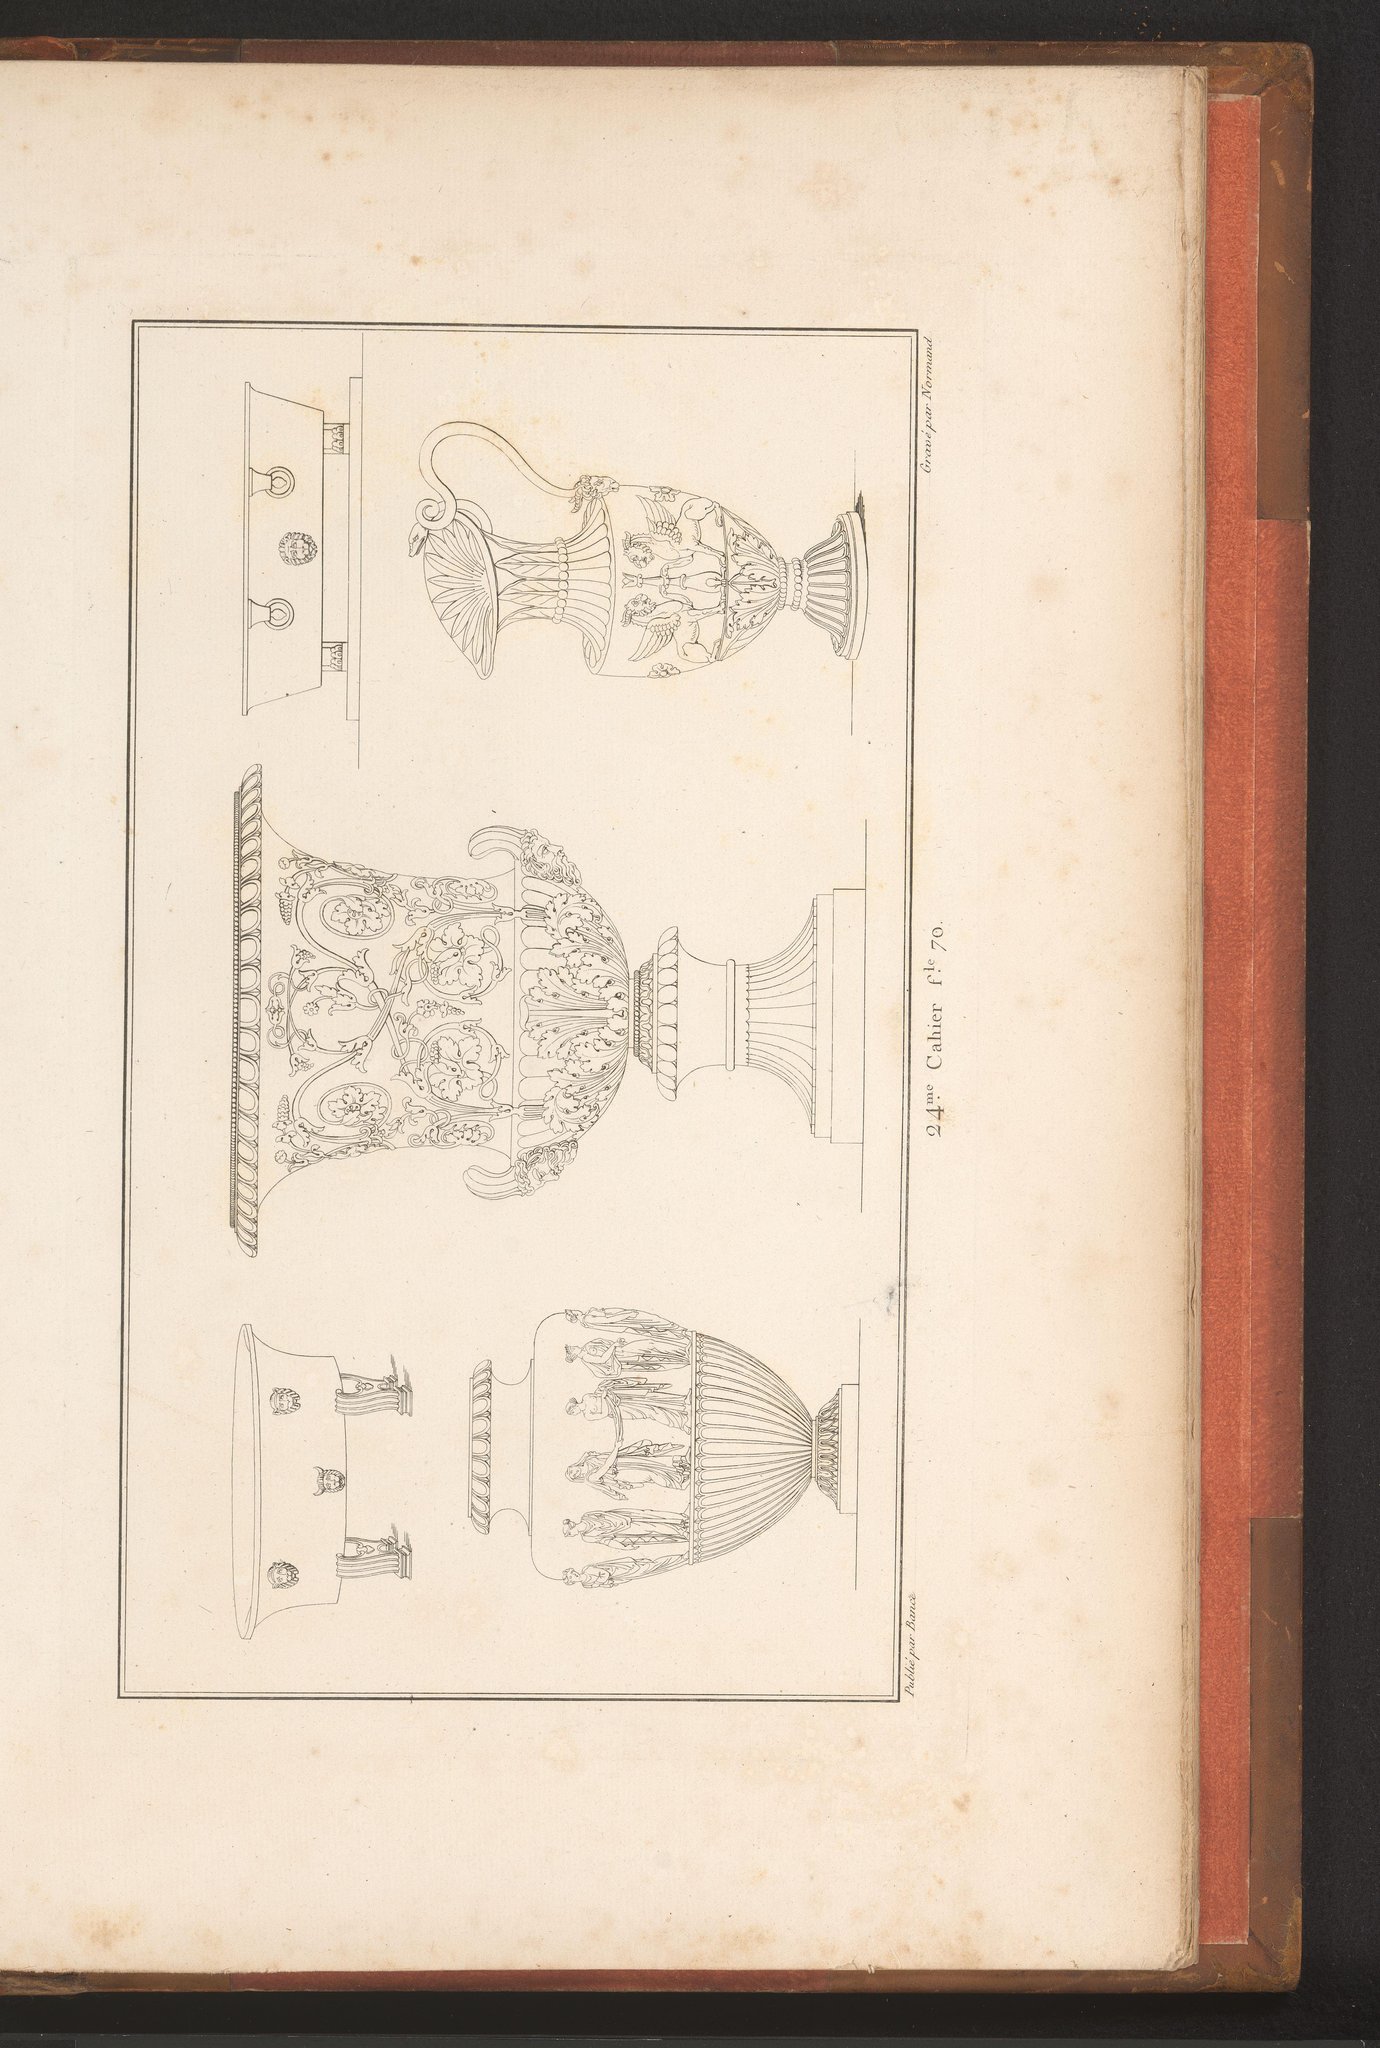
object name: ornament print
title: Vazen en schalen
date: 1820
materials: paper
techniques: etching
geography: paris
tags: vase ~ ornament, garden vase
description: Vazen en schalen. Onderdeel (24e. Cah.er f.le 70) van het prentalbum met twee series van in totaal 138 ornamentprenten door Beauvallet en Normand, 'Fragmens d'Ornemens dans le Style Antique'.